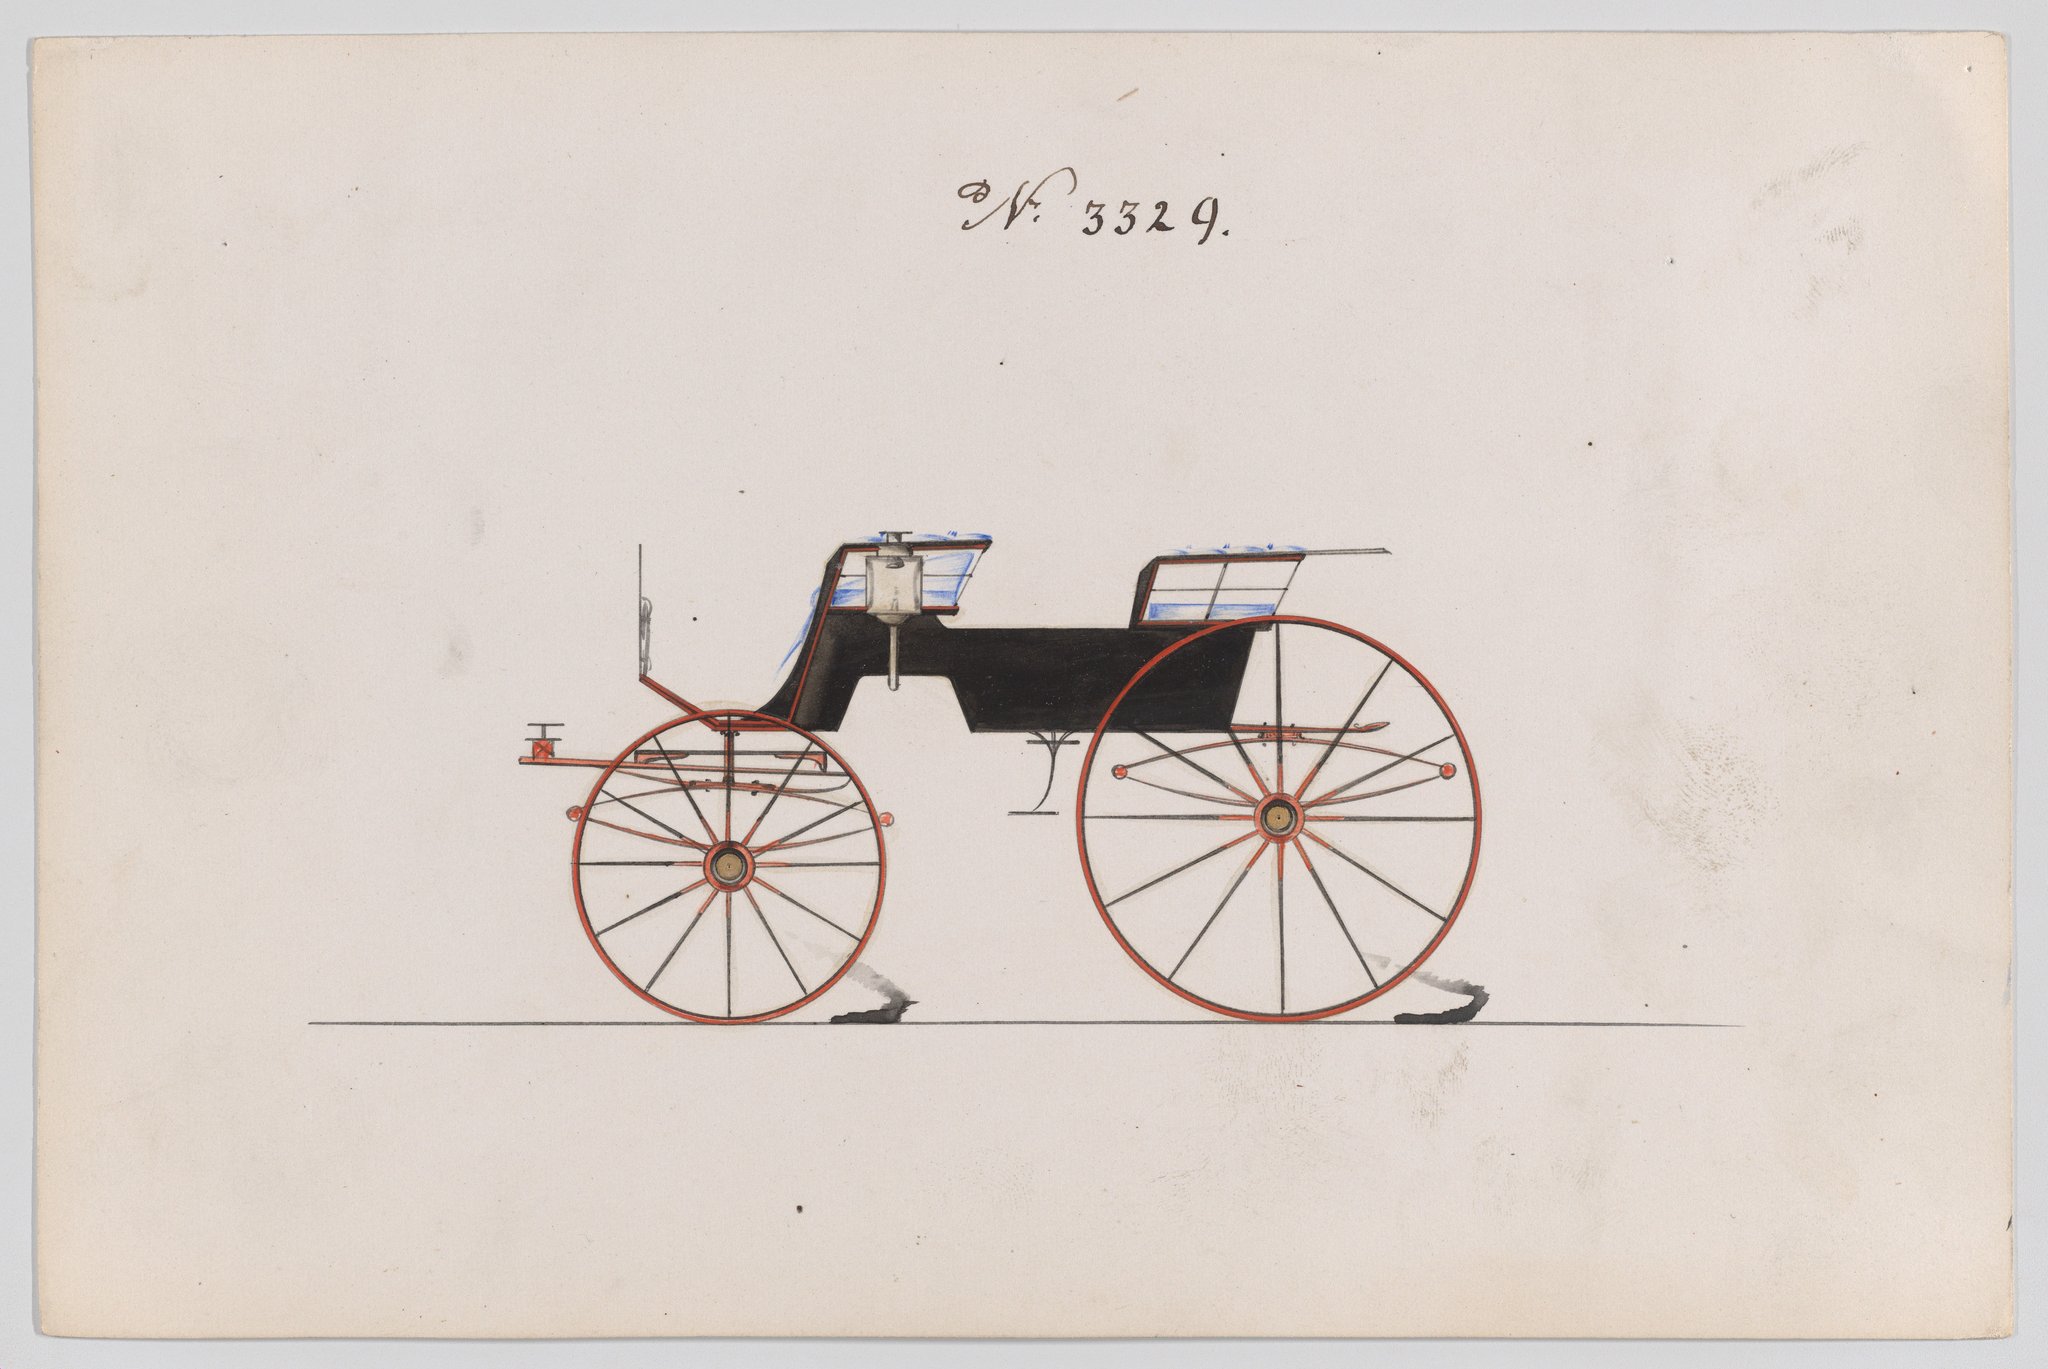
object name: drawing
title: Design for T-Cart, no. 3329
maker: brewster & co.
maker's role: manufacturer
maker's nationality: american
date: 1877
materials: gouache, gum arabic, ink, watercolor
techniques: pen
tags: carriages